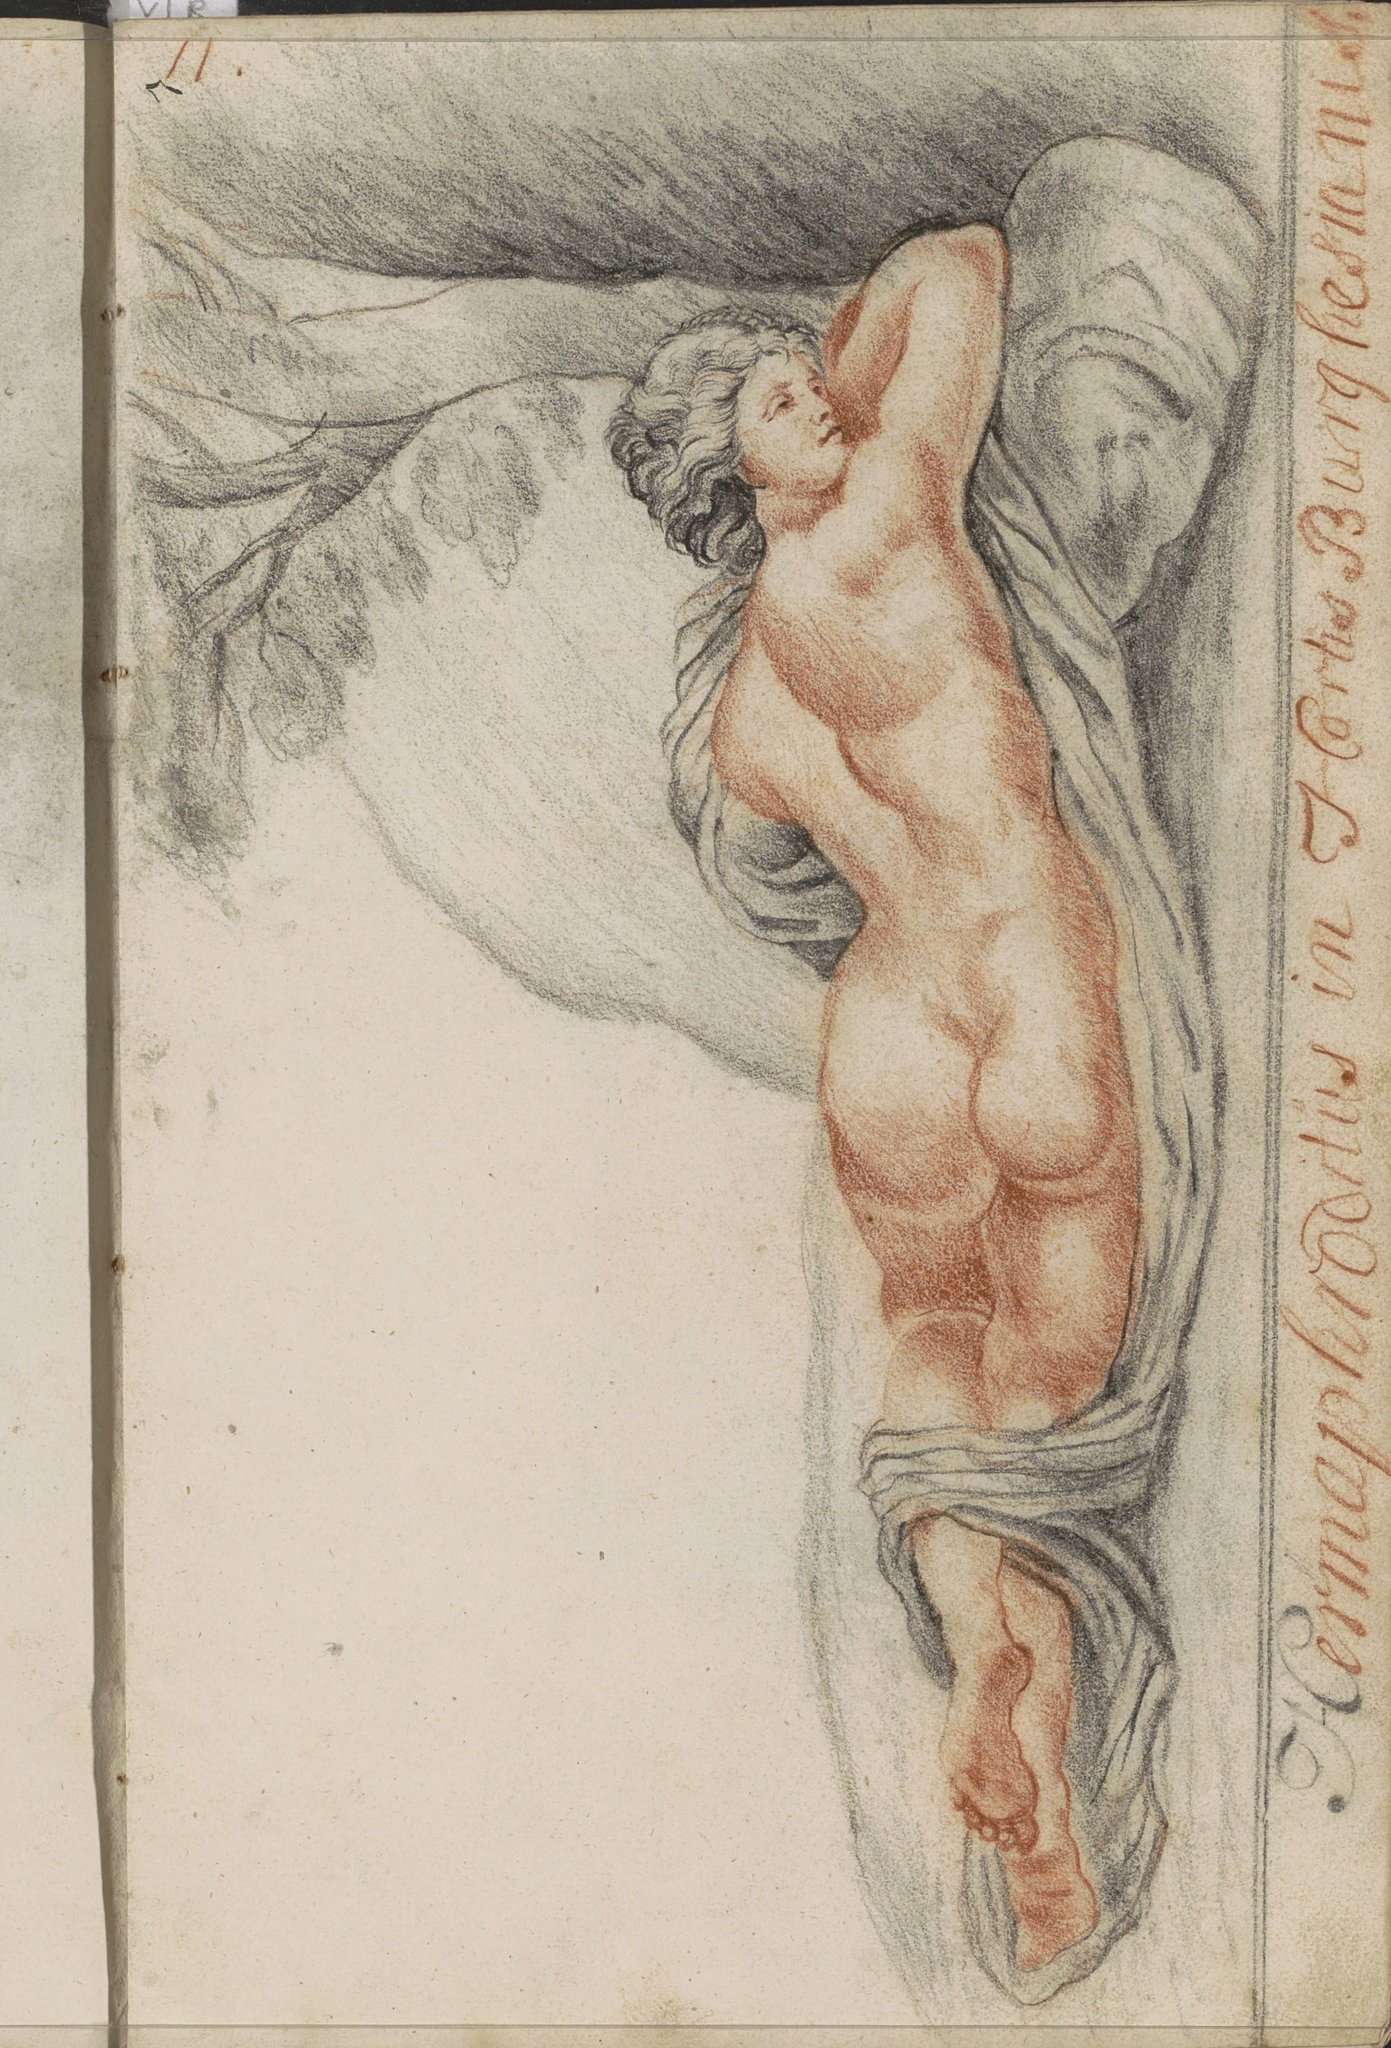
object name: sketchbook leaf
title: Hermaphroditus liggend in de Farnese tuinen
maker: hendrick van beaumont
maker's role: draughtsman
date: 1696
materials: chalk, paper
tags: (story of) hermaphroditus, garden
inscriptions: number: ‘11.’, annotation: ‘Hermaphroditus in Hortis Burghesianis’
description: Getekend naar een Romeins sculptuur (of prent van de sculptuur) van Hermaphroditus in de Villa Borghese.